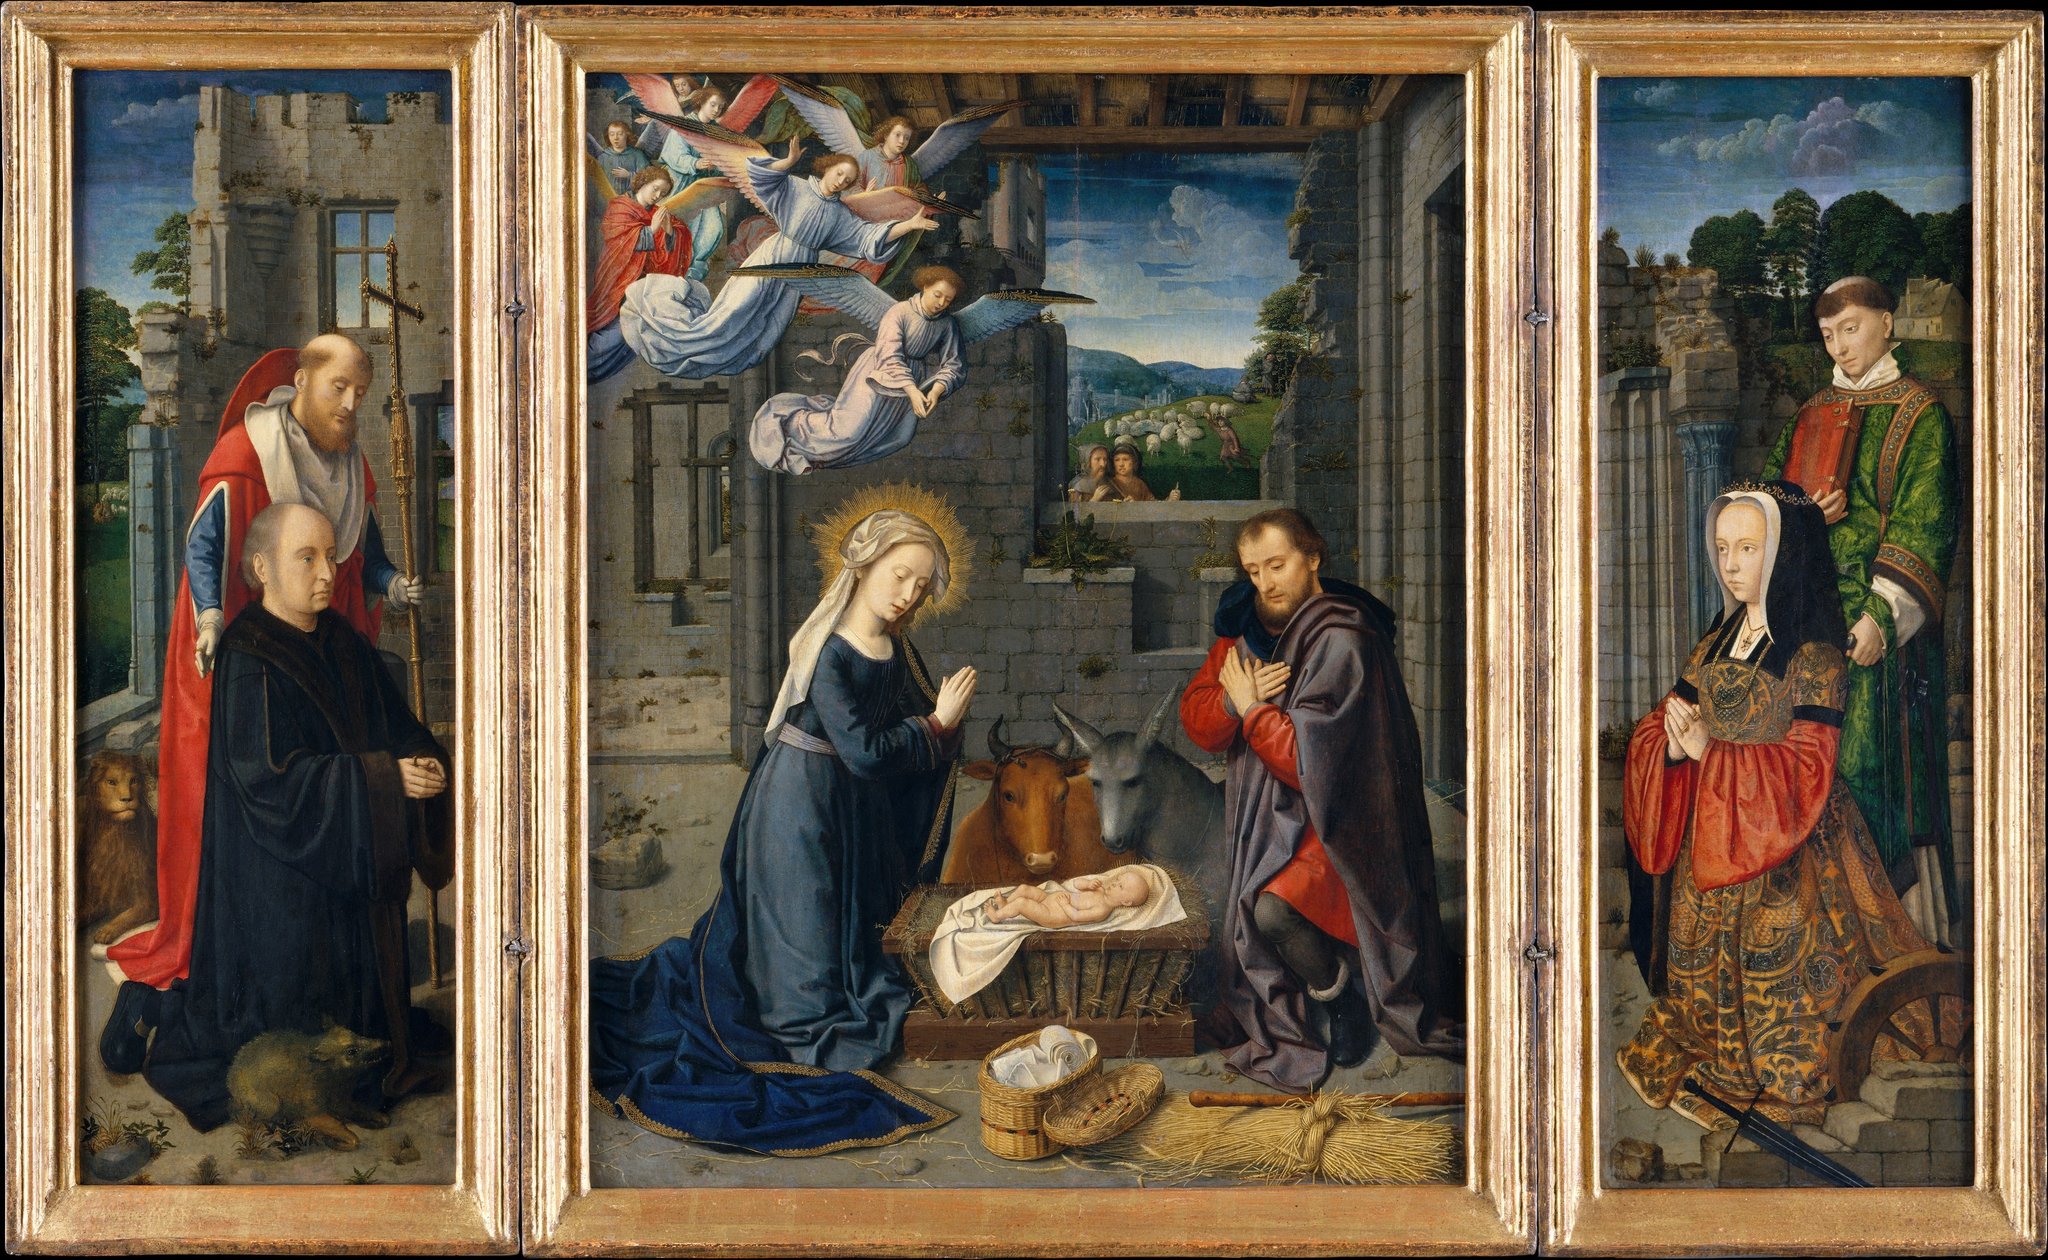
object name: painting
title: The Nativity with Donors and Saints Jerome and Leonard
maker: gerard david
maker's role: artist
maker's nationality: netherlandish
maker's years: 1455-1523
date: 1510-1515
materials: canvas, oil, wood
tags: cows,donkeys,lions,angels,saint jerome,saint leonard,virgin mary,nativity